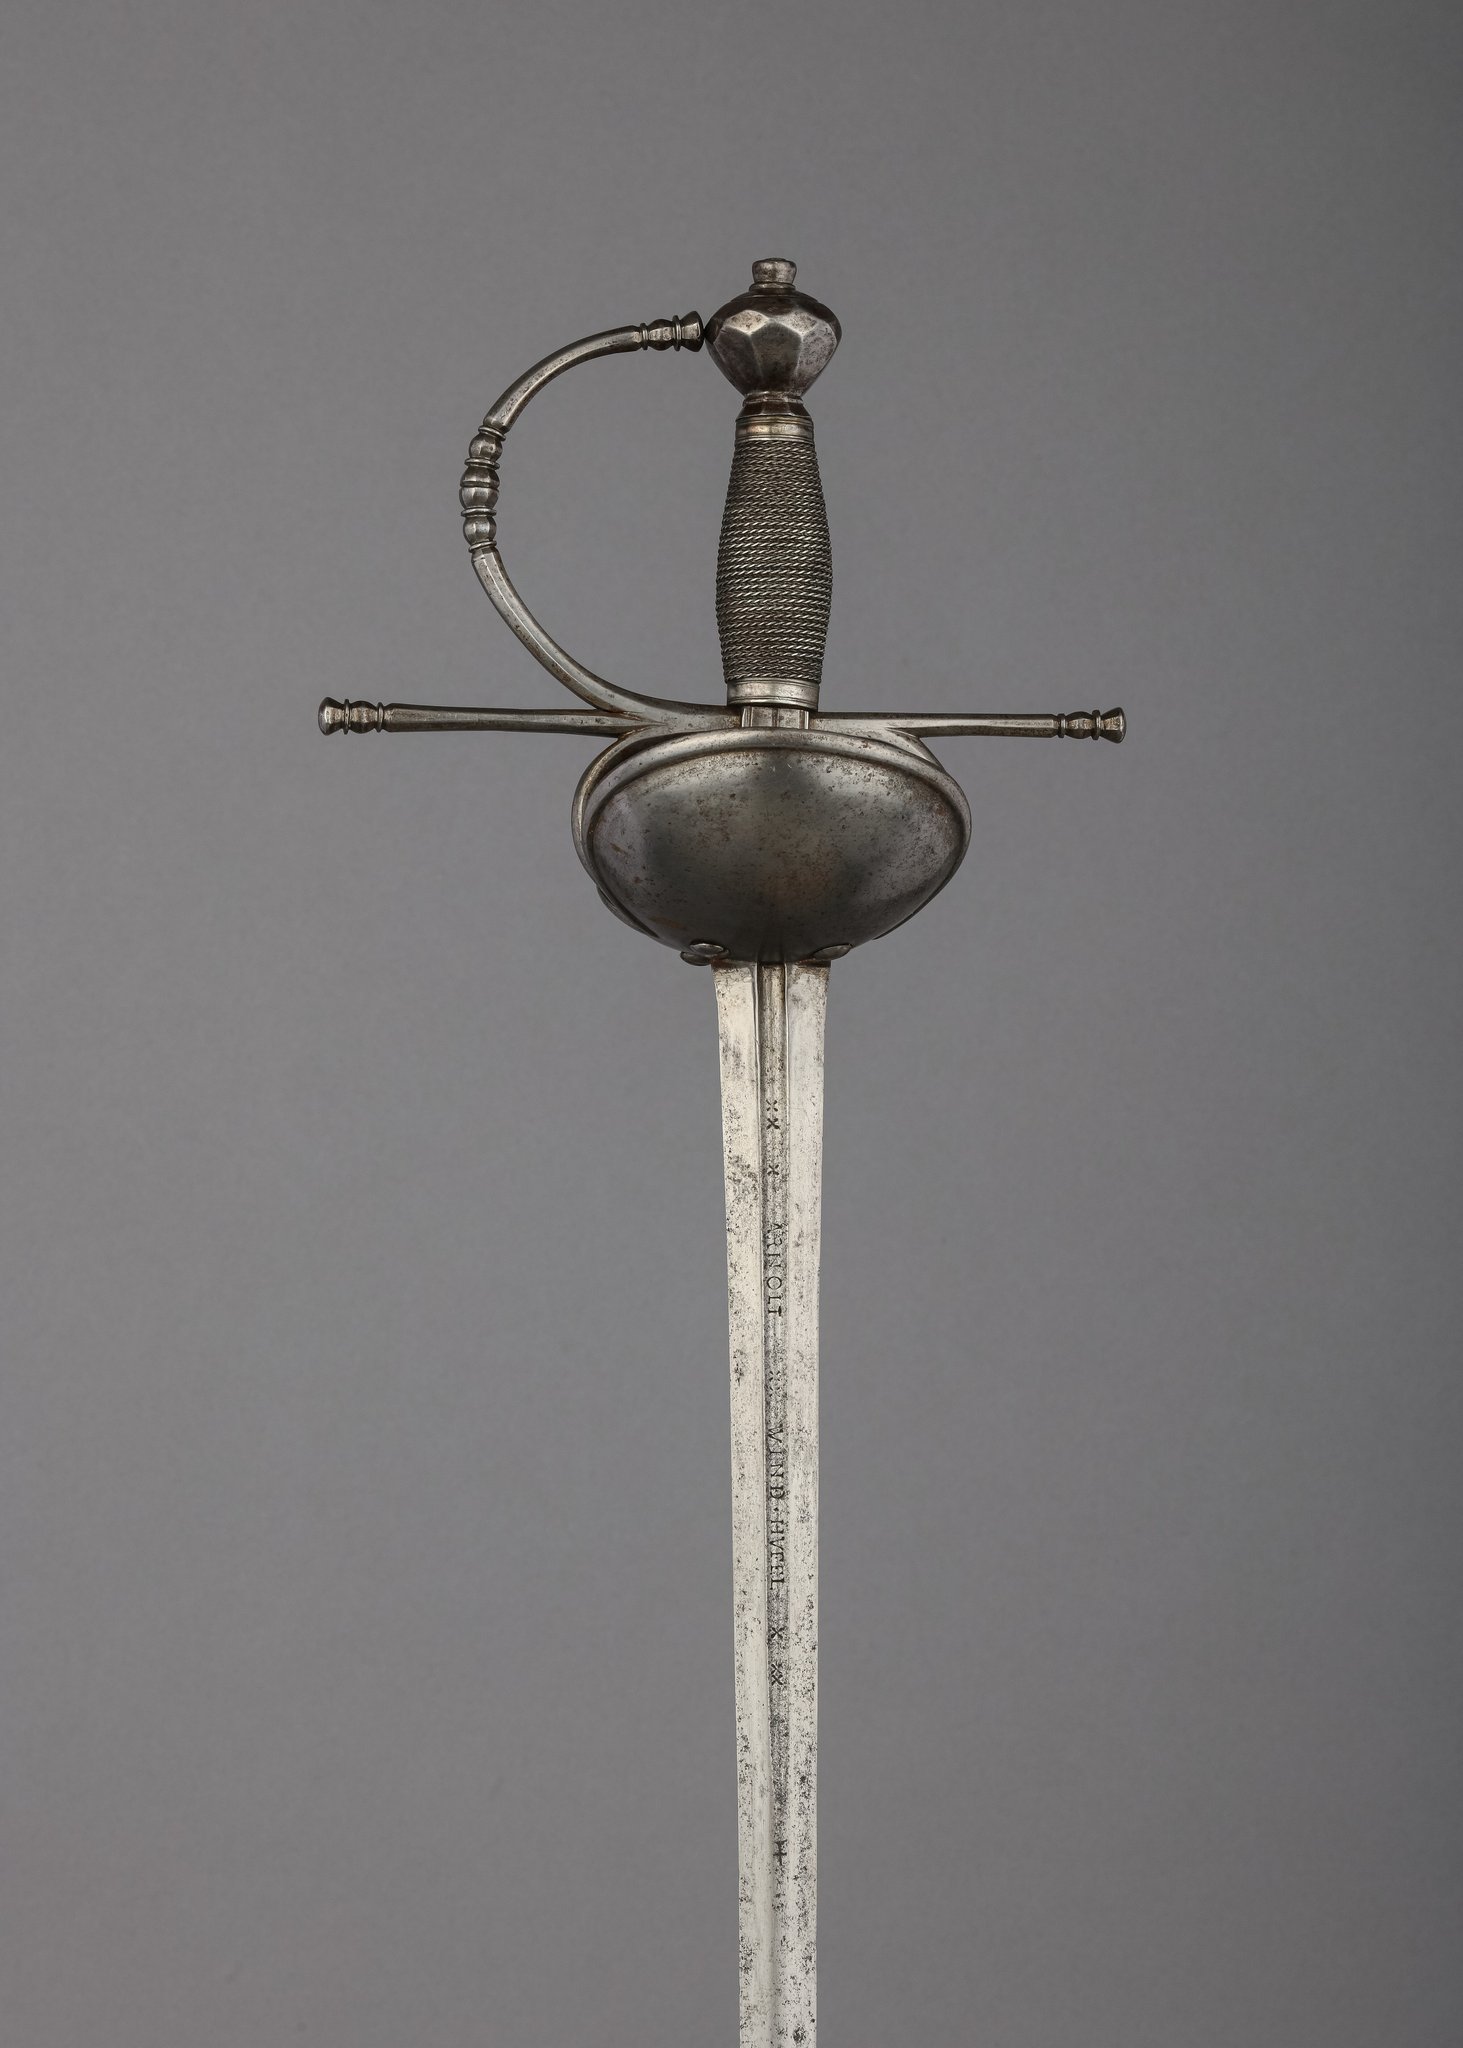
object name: rapier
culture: spanish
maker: arnolt windhvfel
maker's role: bladesmith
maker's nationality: german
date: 1701-1800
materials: silver, steel, wood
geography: germany